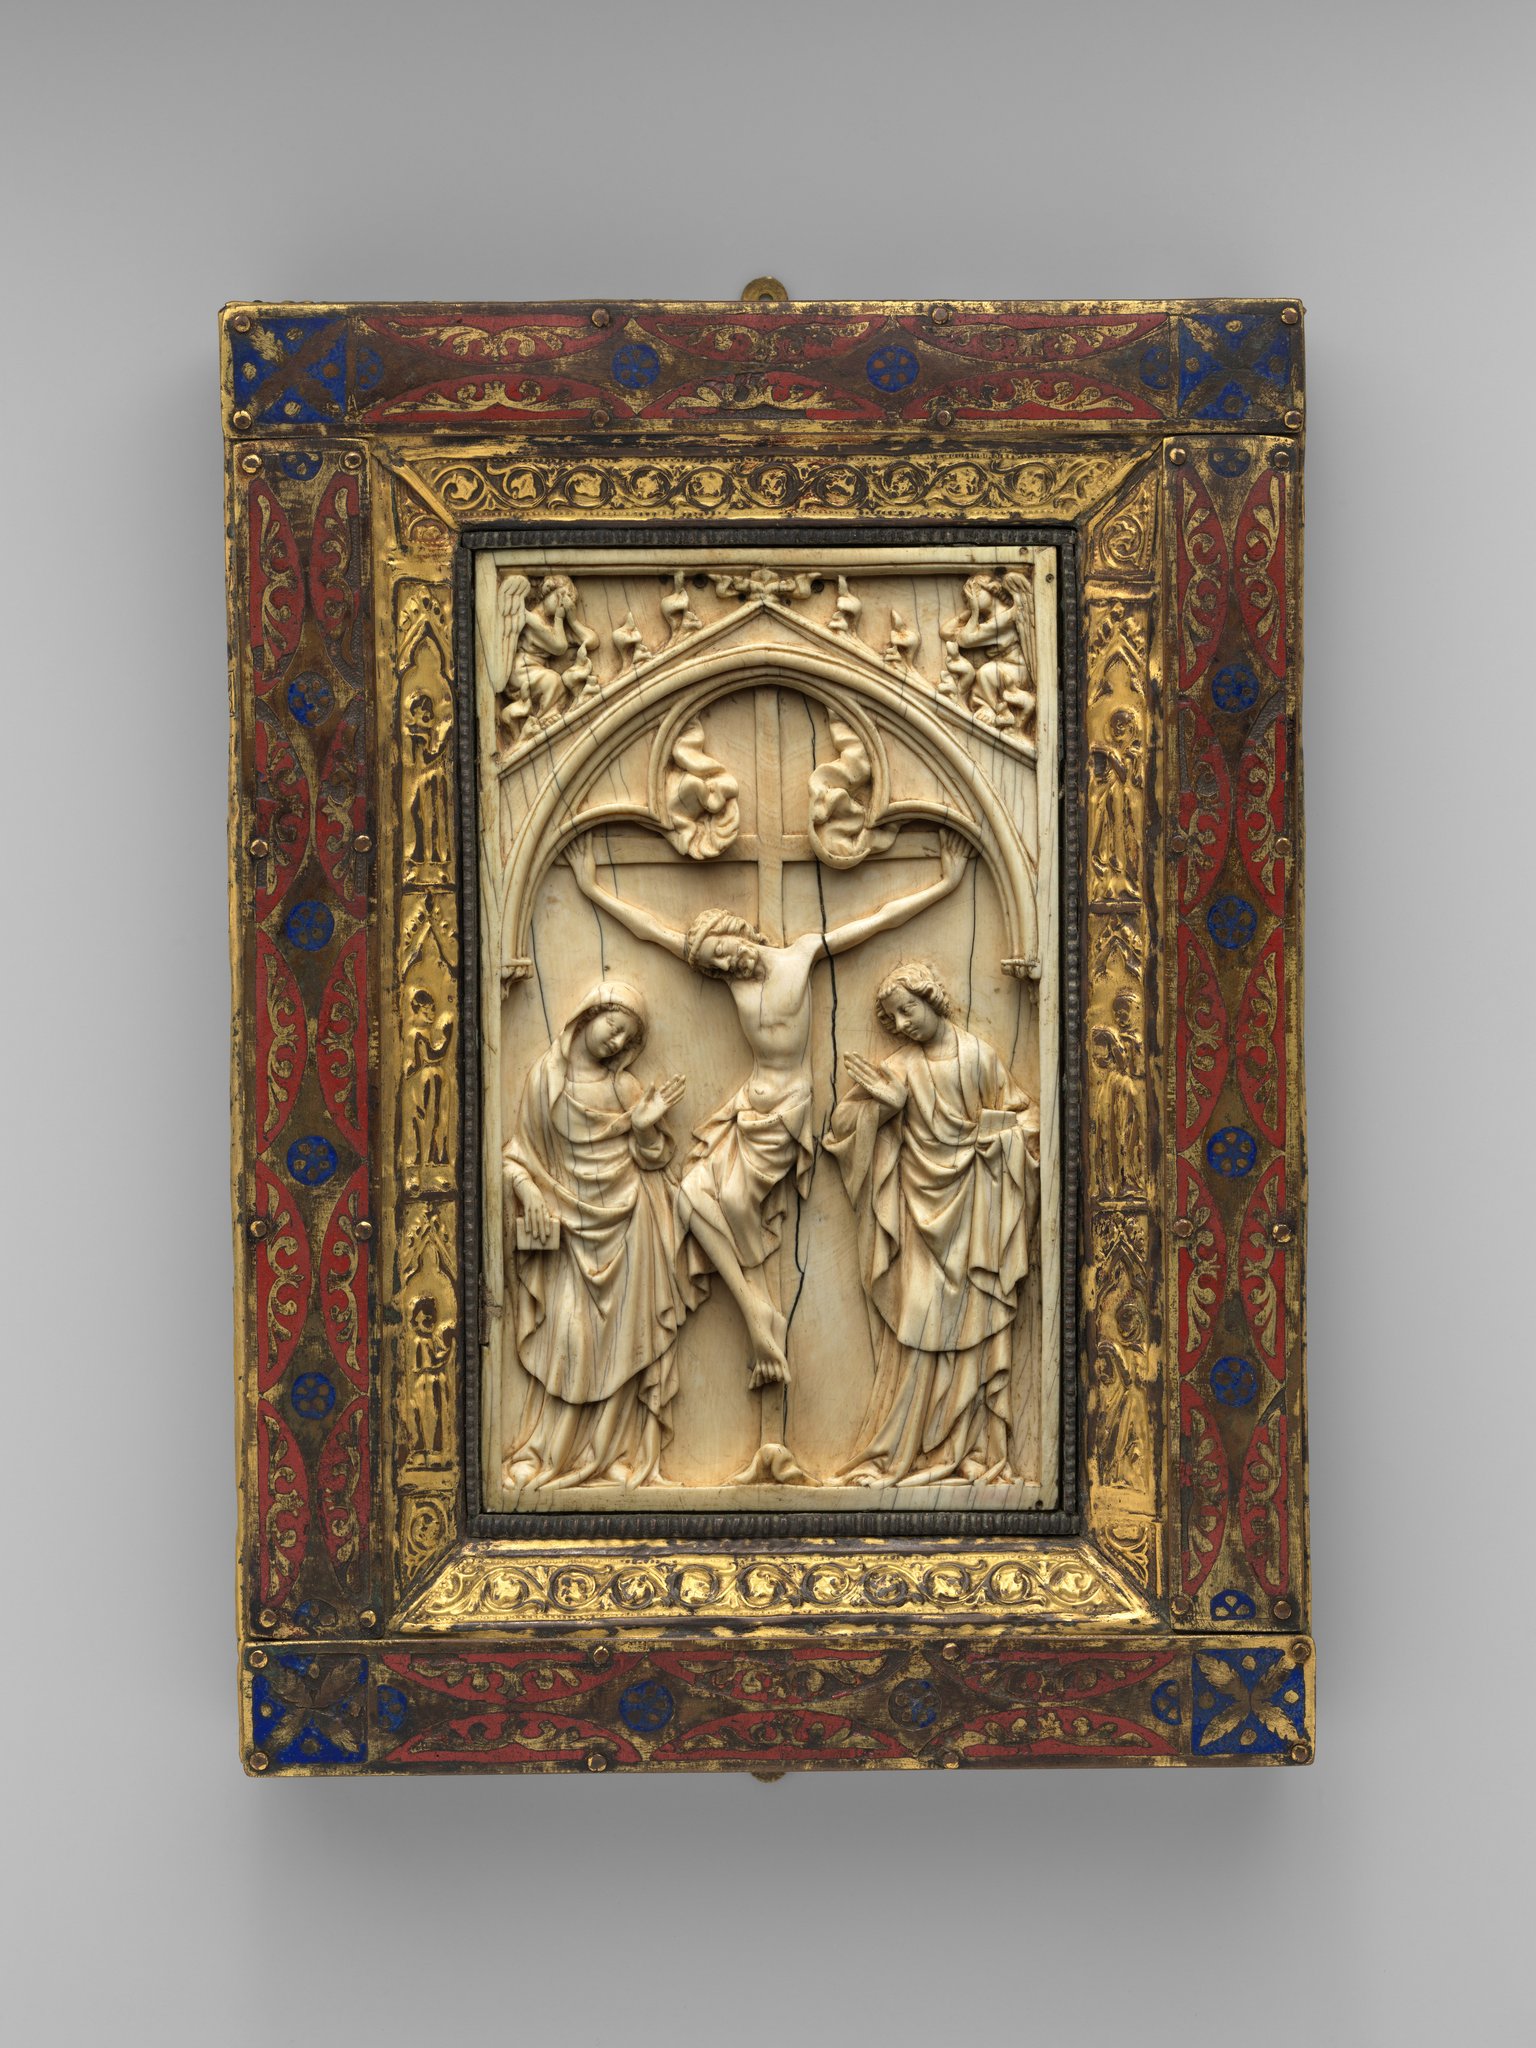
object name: book cover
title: Book Cover with Crucifixion Panel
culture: french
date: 1326-1350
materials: gilt copper, enamel, ivory, wood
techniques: enamel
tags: virgin mary,crucifixion